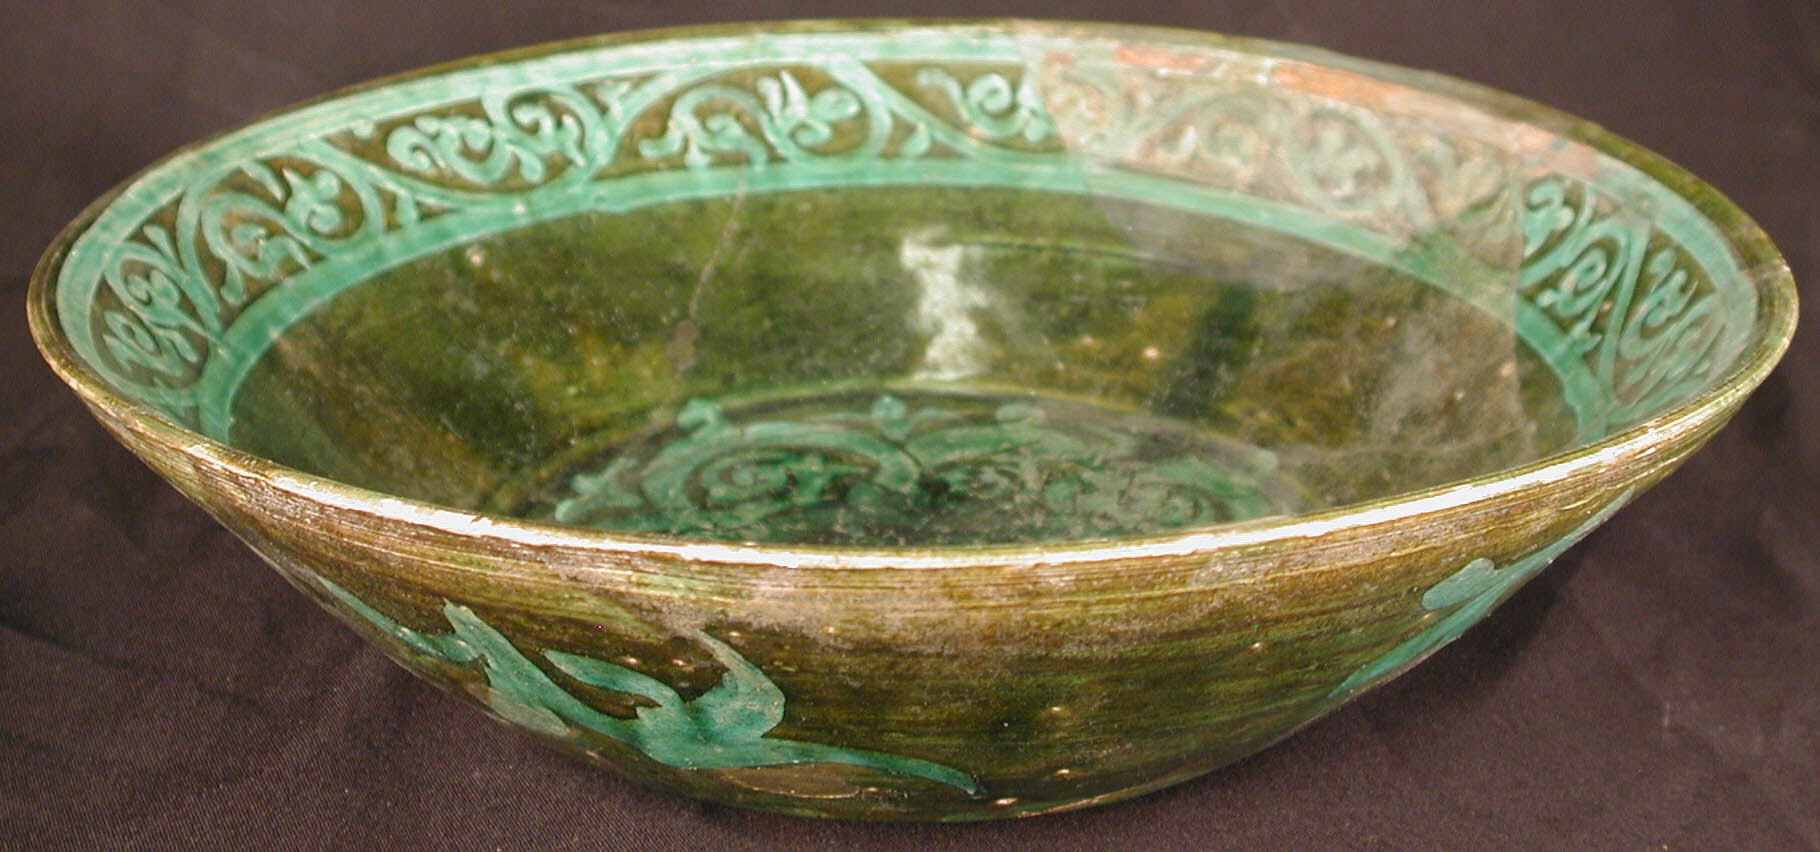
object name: bowl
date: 801-1000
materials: earthenware, glaze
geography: iran